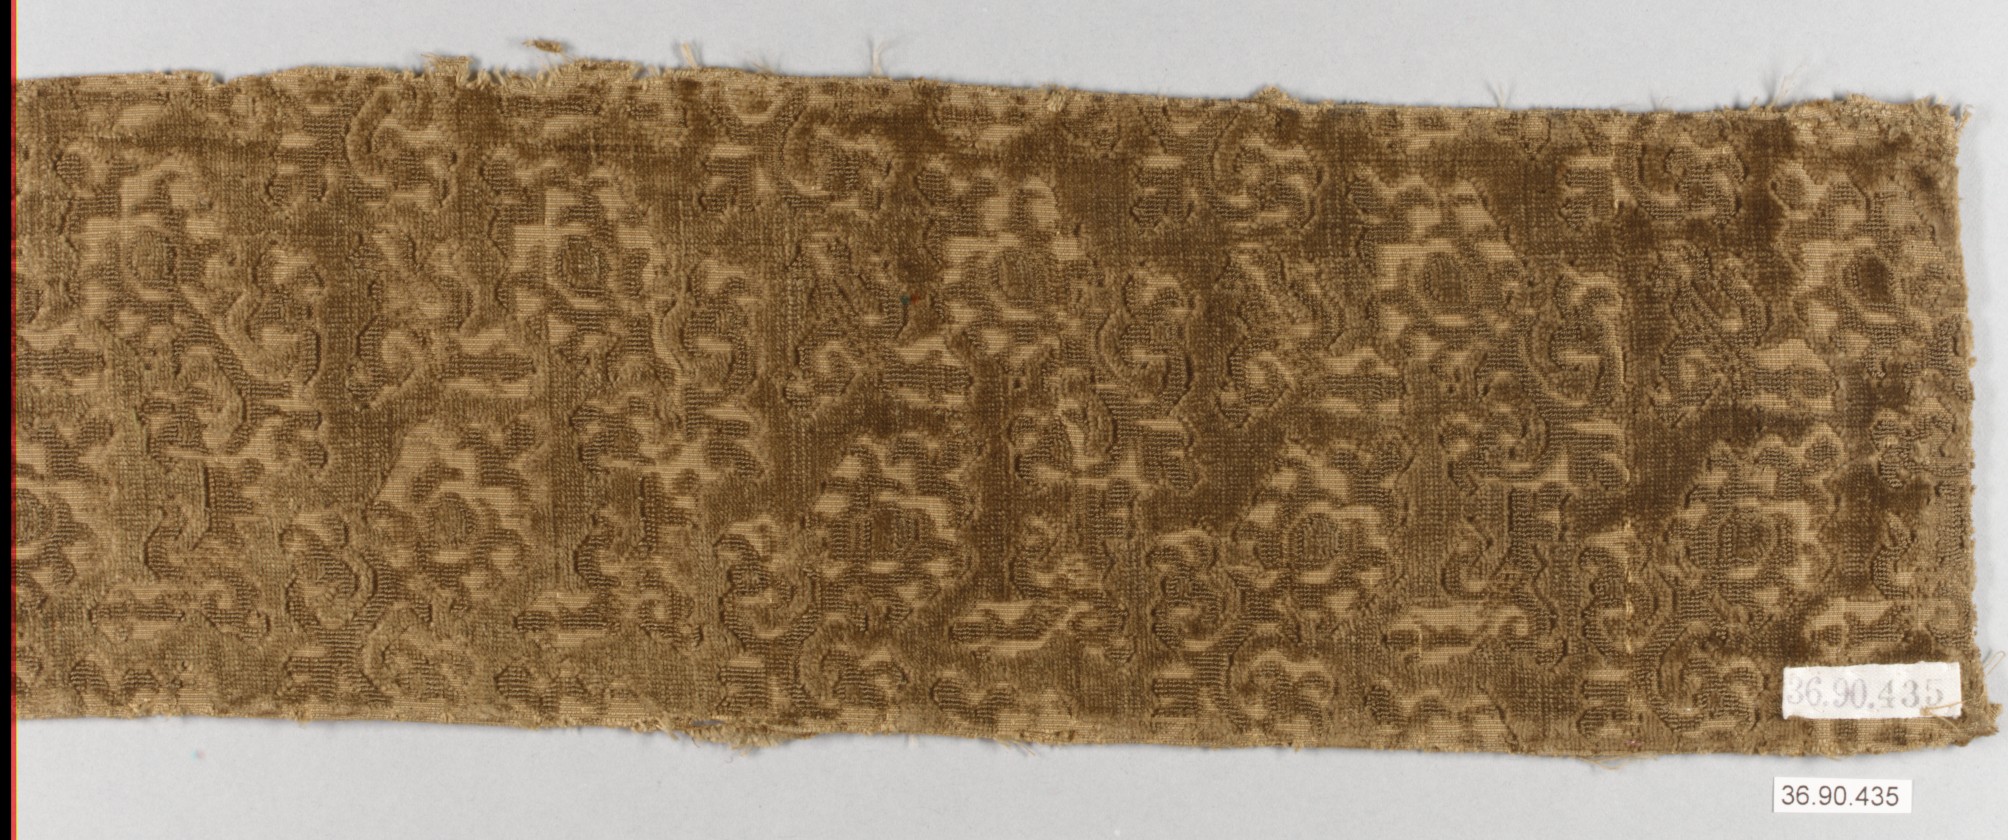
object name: piece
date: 1501-1700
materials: silk